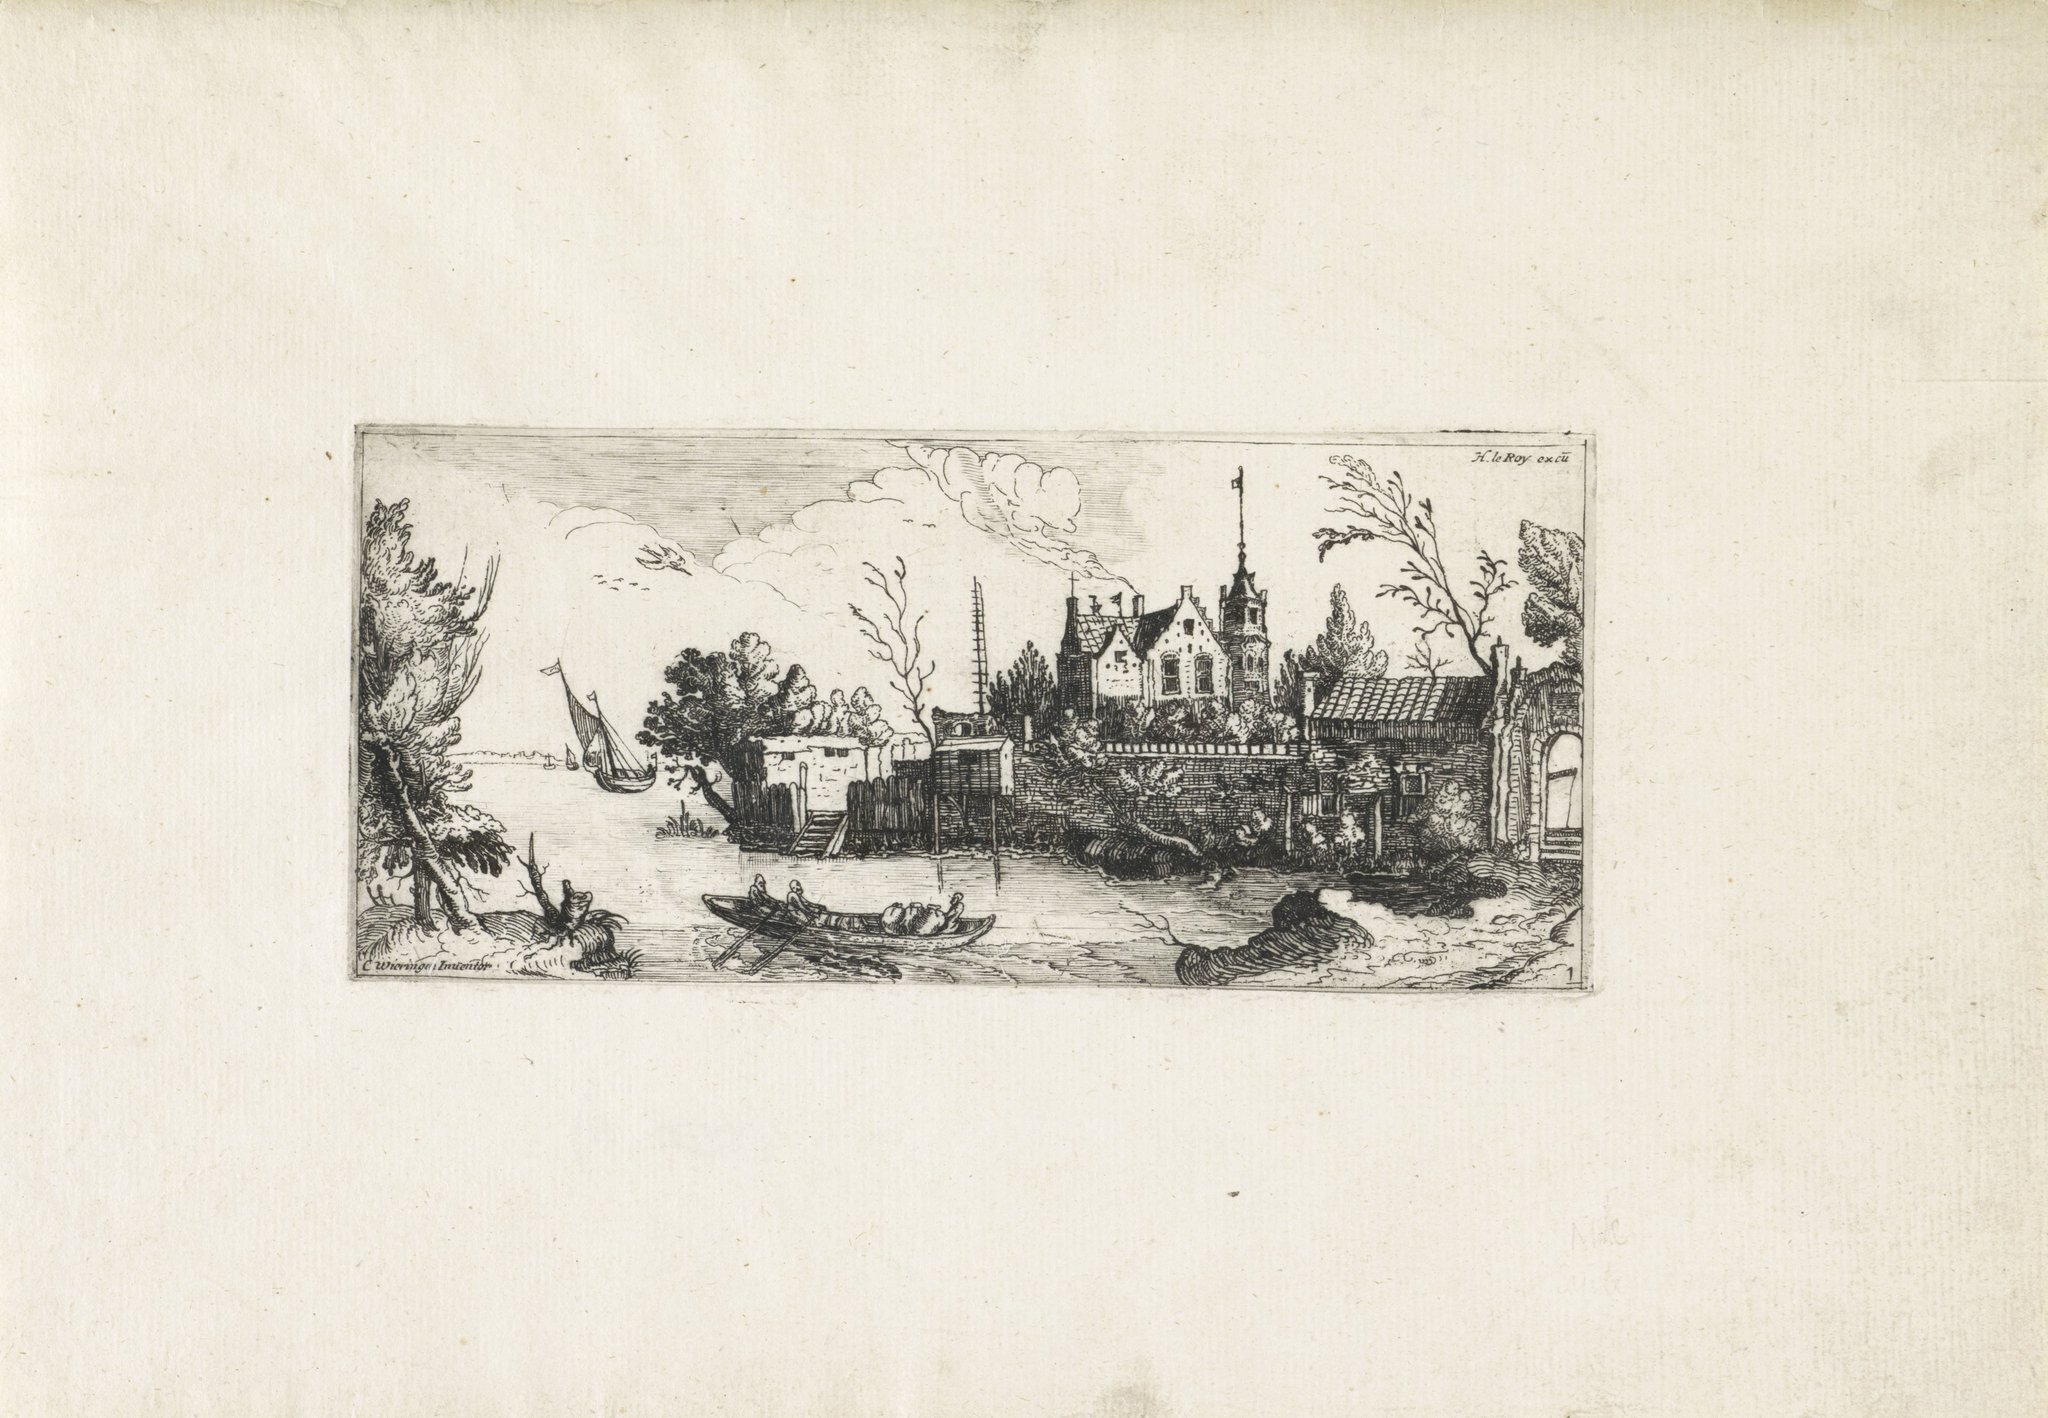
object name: print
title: Landschappen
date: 1614-1618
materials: paper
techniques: etching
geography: haarlem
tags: river, rowing-boat, canoe, etc.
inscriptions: collector's mark: Lugt 2760, collector's mark: Lugt 2228